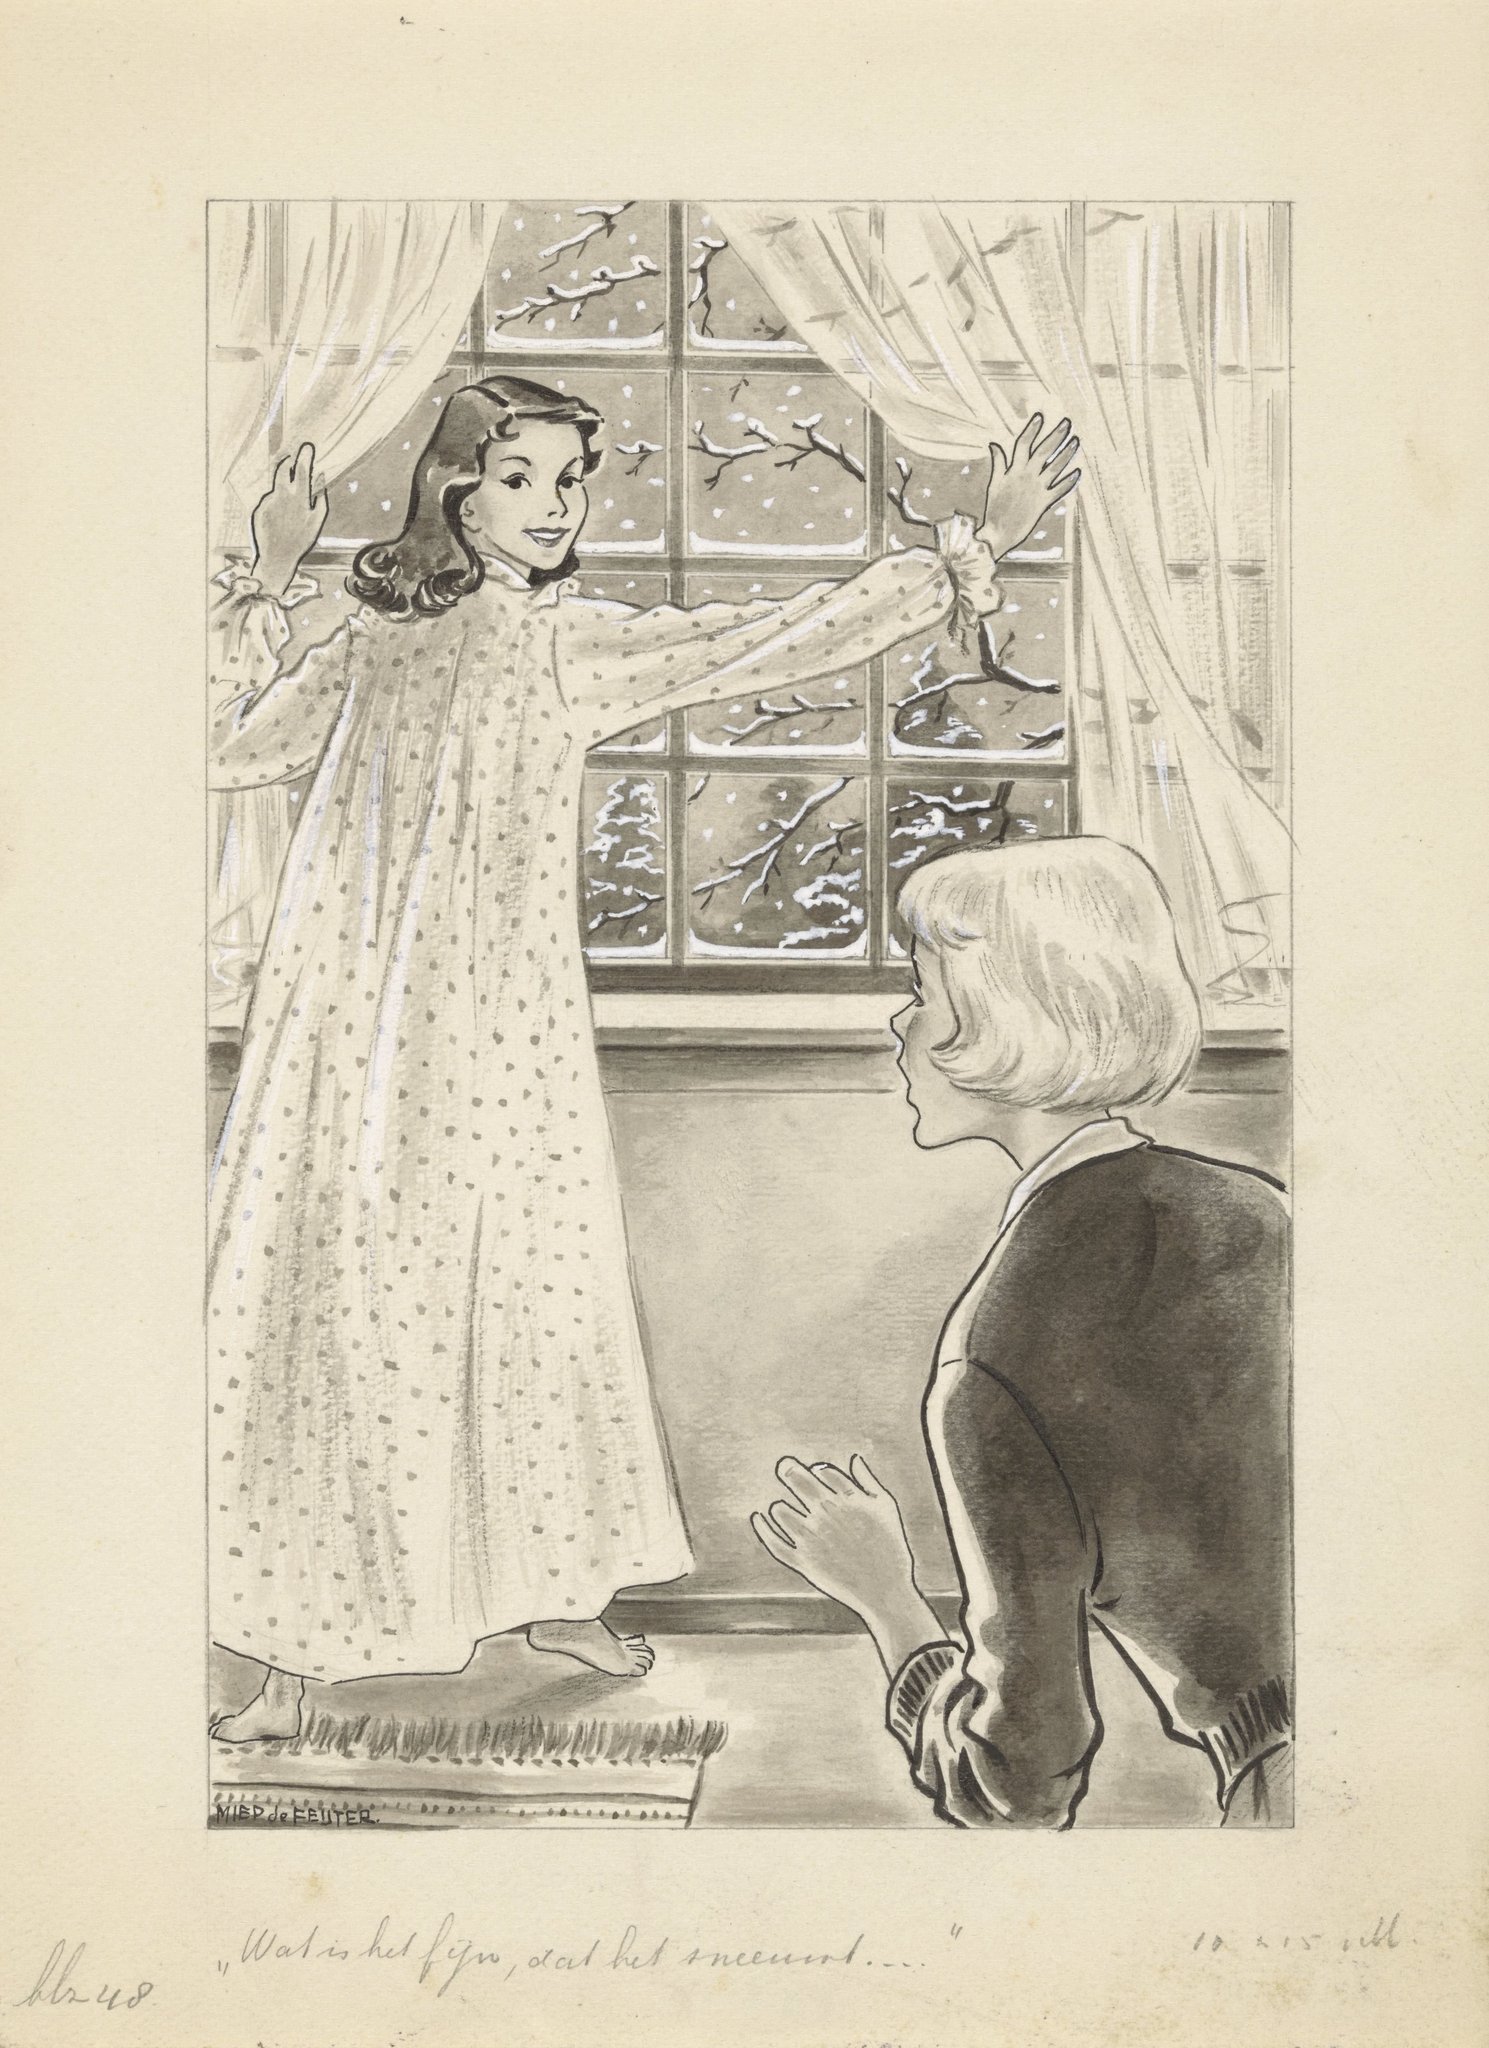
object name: drawing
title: Twee meisjes kijken naar de sneeuw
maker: miep de feijter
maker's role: draughtsman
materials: paint, ink, paper, pencil, watercolor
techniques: brush, pen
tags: window, snow, nightwear: night-gown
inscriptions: collector's mark: Lugt 2228a, signature: ‘MIEP de FEIJTER.’, :, annotation: ‘blz 48 "Wat is het fijn, dat het sneeuwt ...."’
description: Een meisje in een nachtjapon staat voor een raam. Ze doet de gordijnen open en kijkt om naar een tweede meisje in de kamer. Door het venster is te zien dat het sneeuwt.